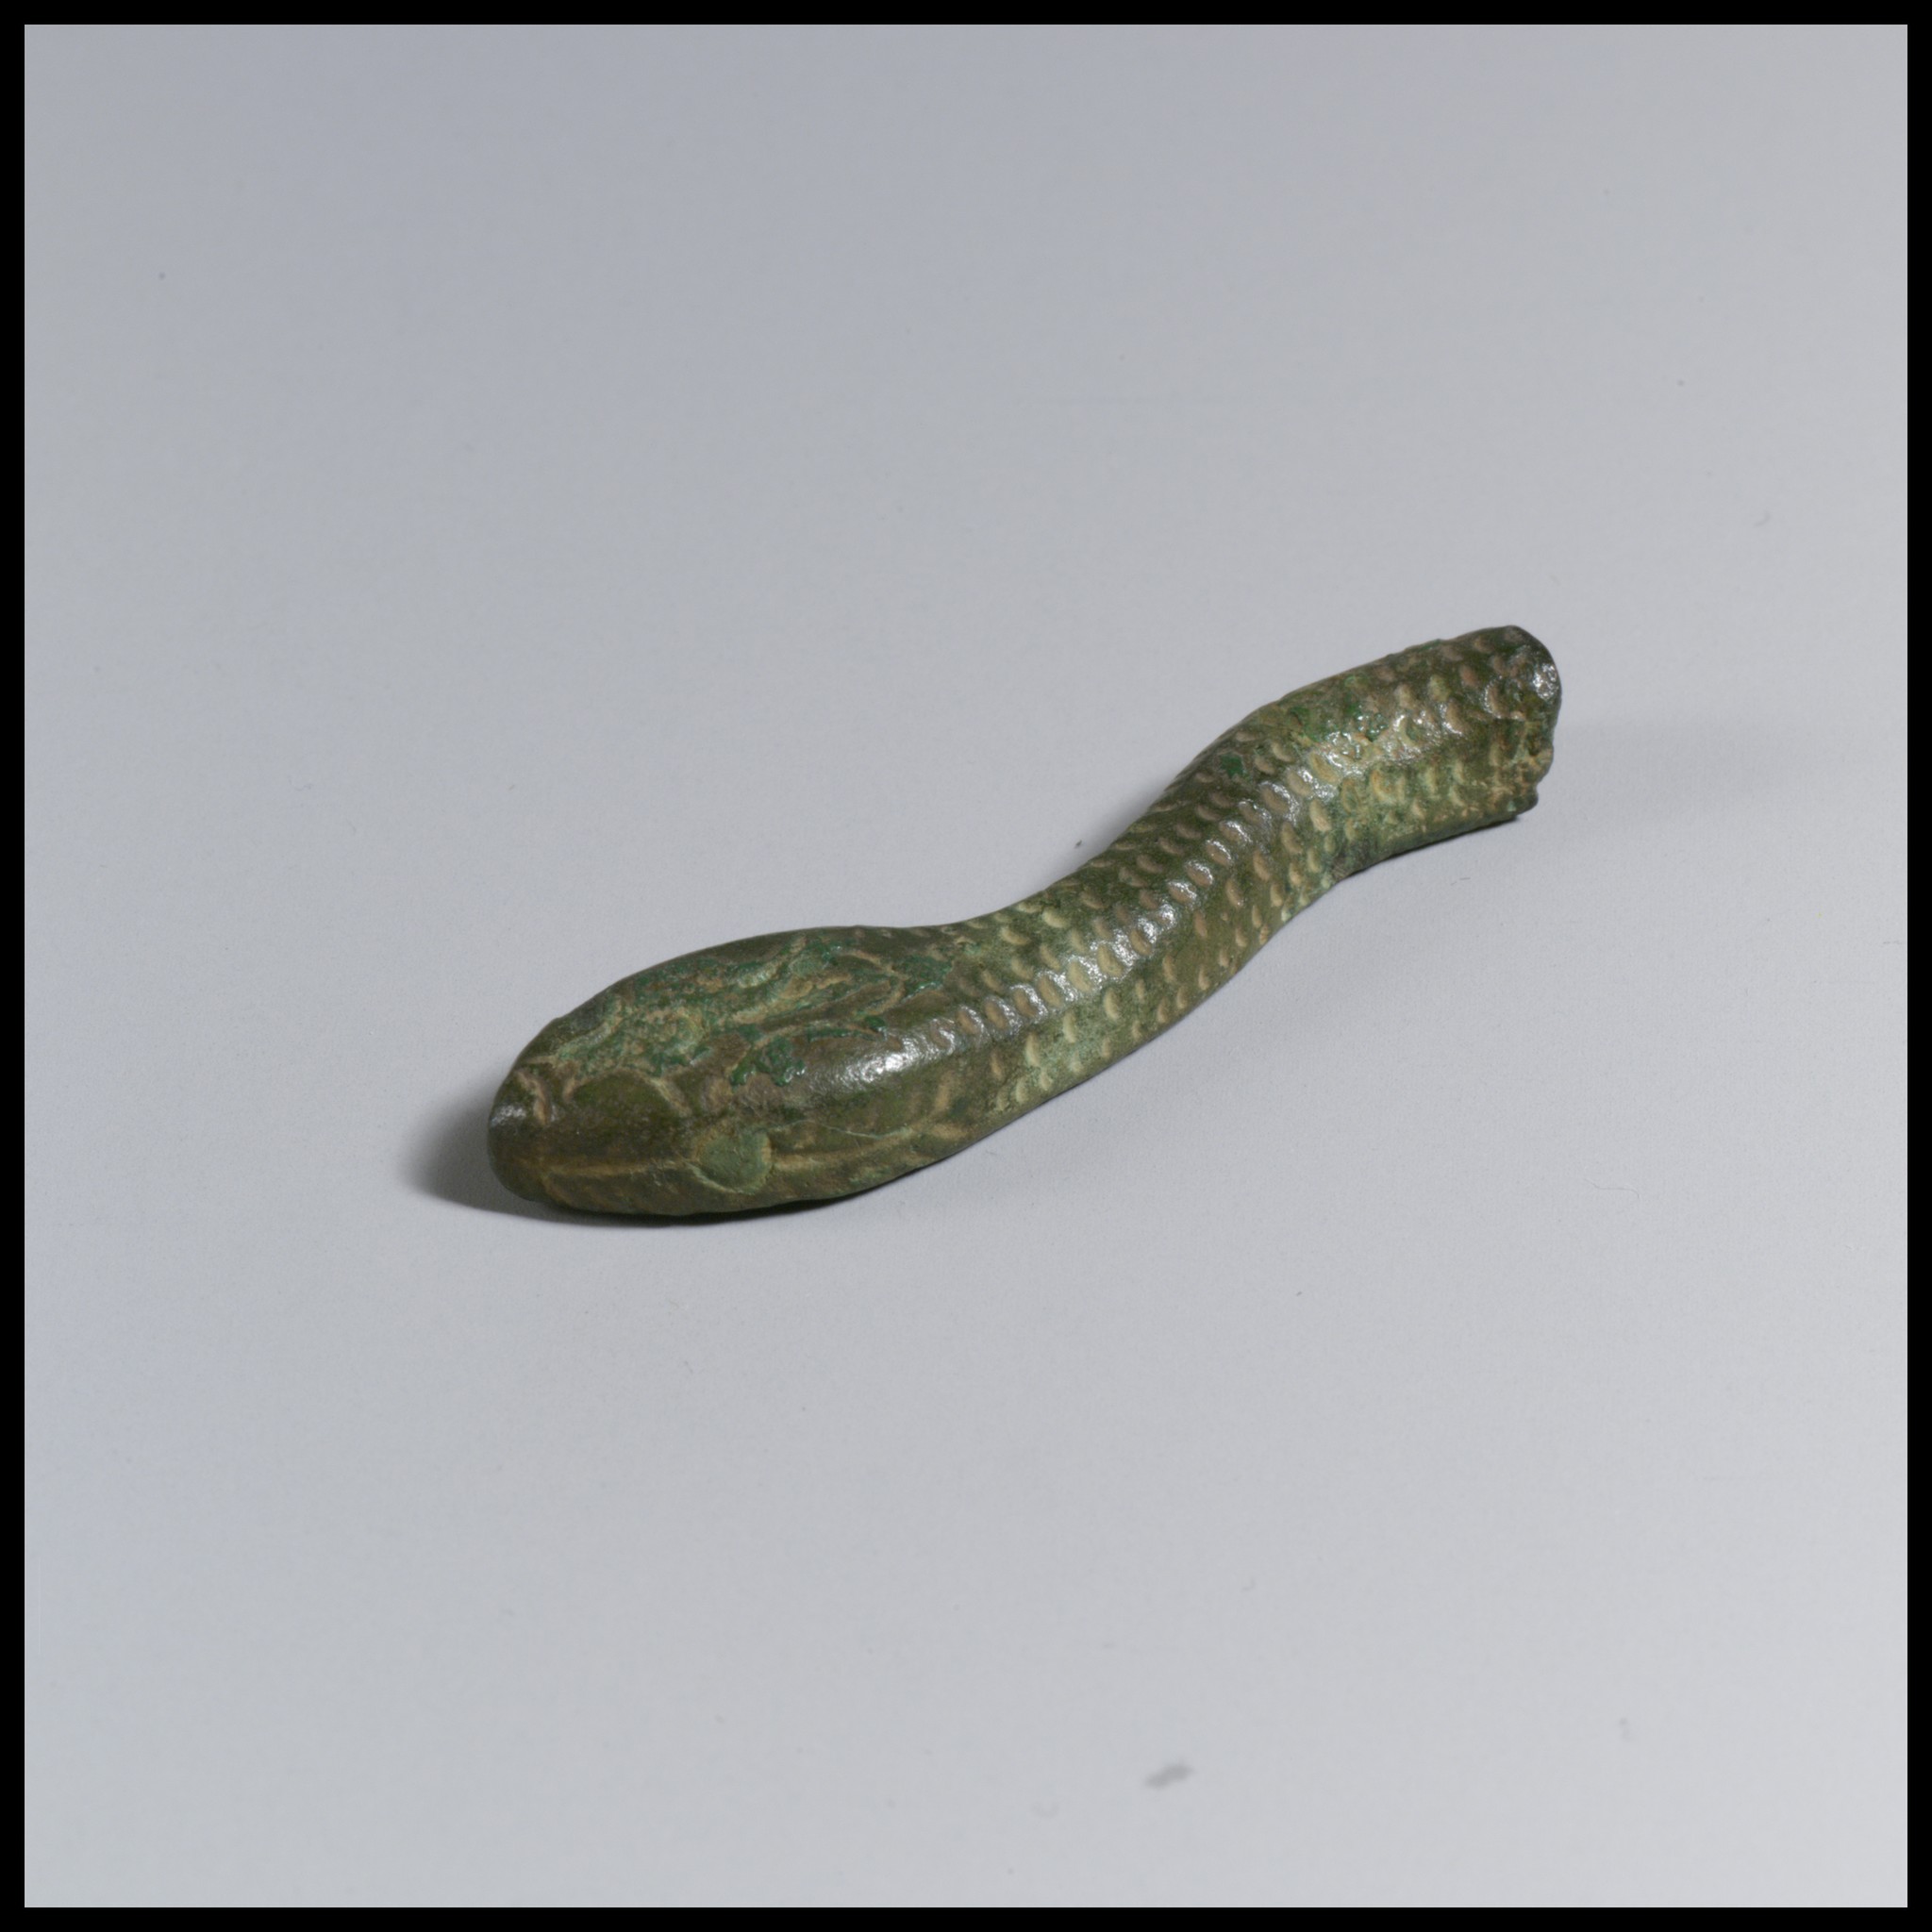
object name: statuette of a snake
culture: roman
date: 670 BCE-330 CE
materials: bronze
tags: snakes